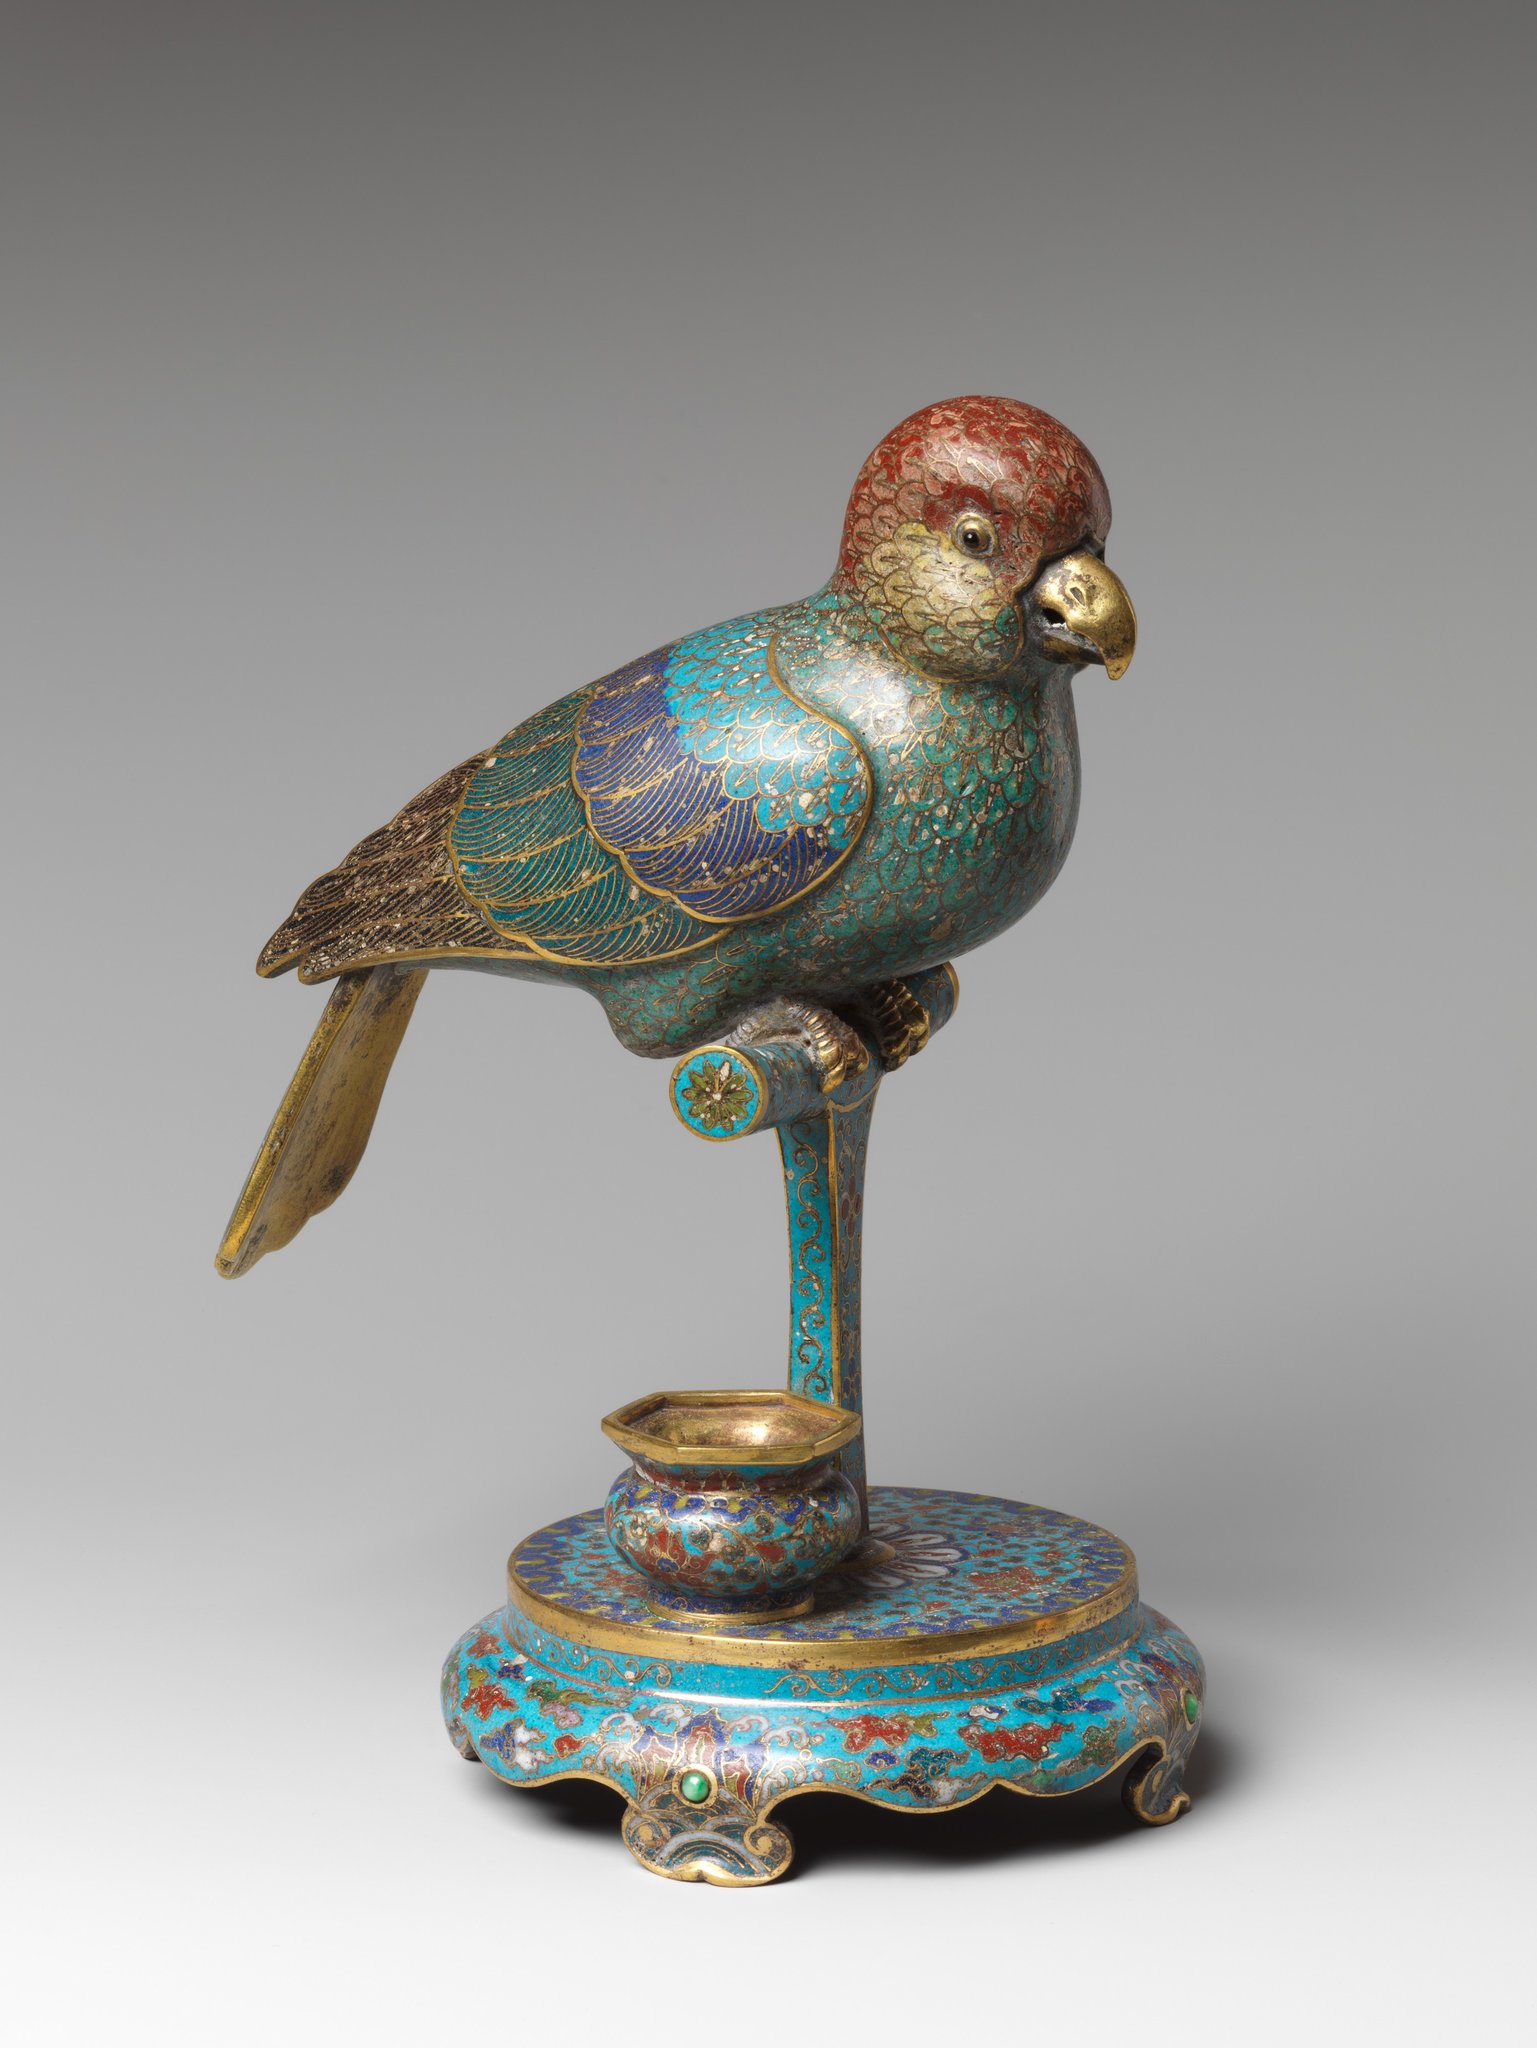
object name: parakeet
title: One of a pair of parakeets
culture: chinese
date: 1734-1766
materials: enamel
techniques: enamel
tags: birds